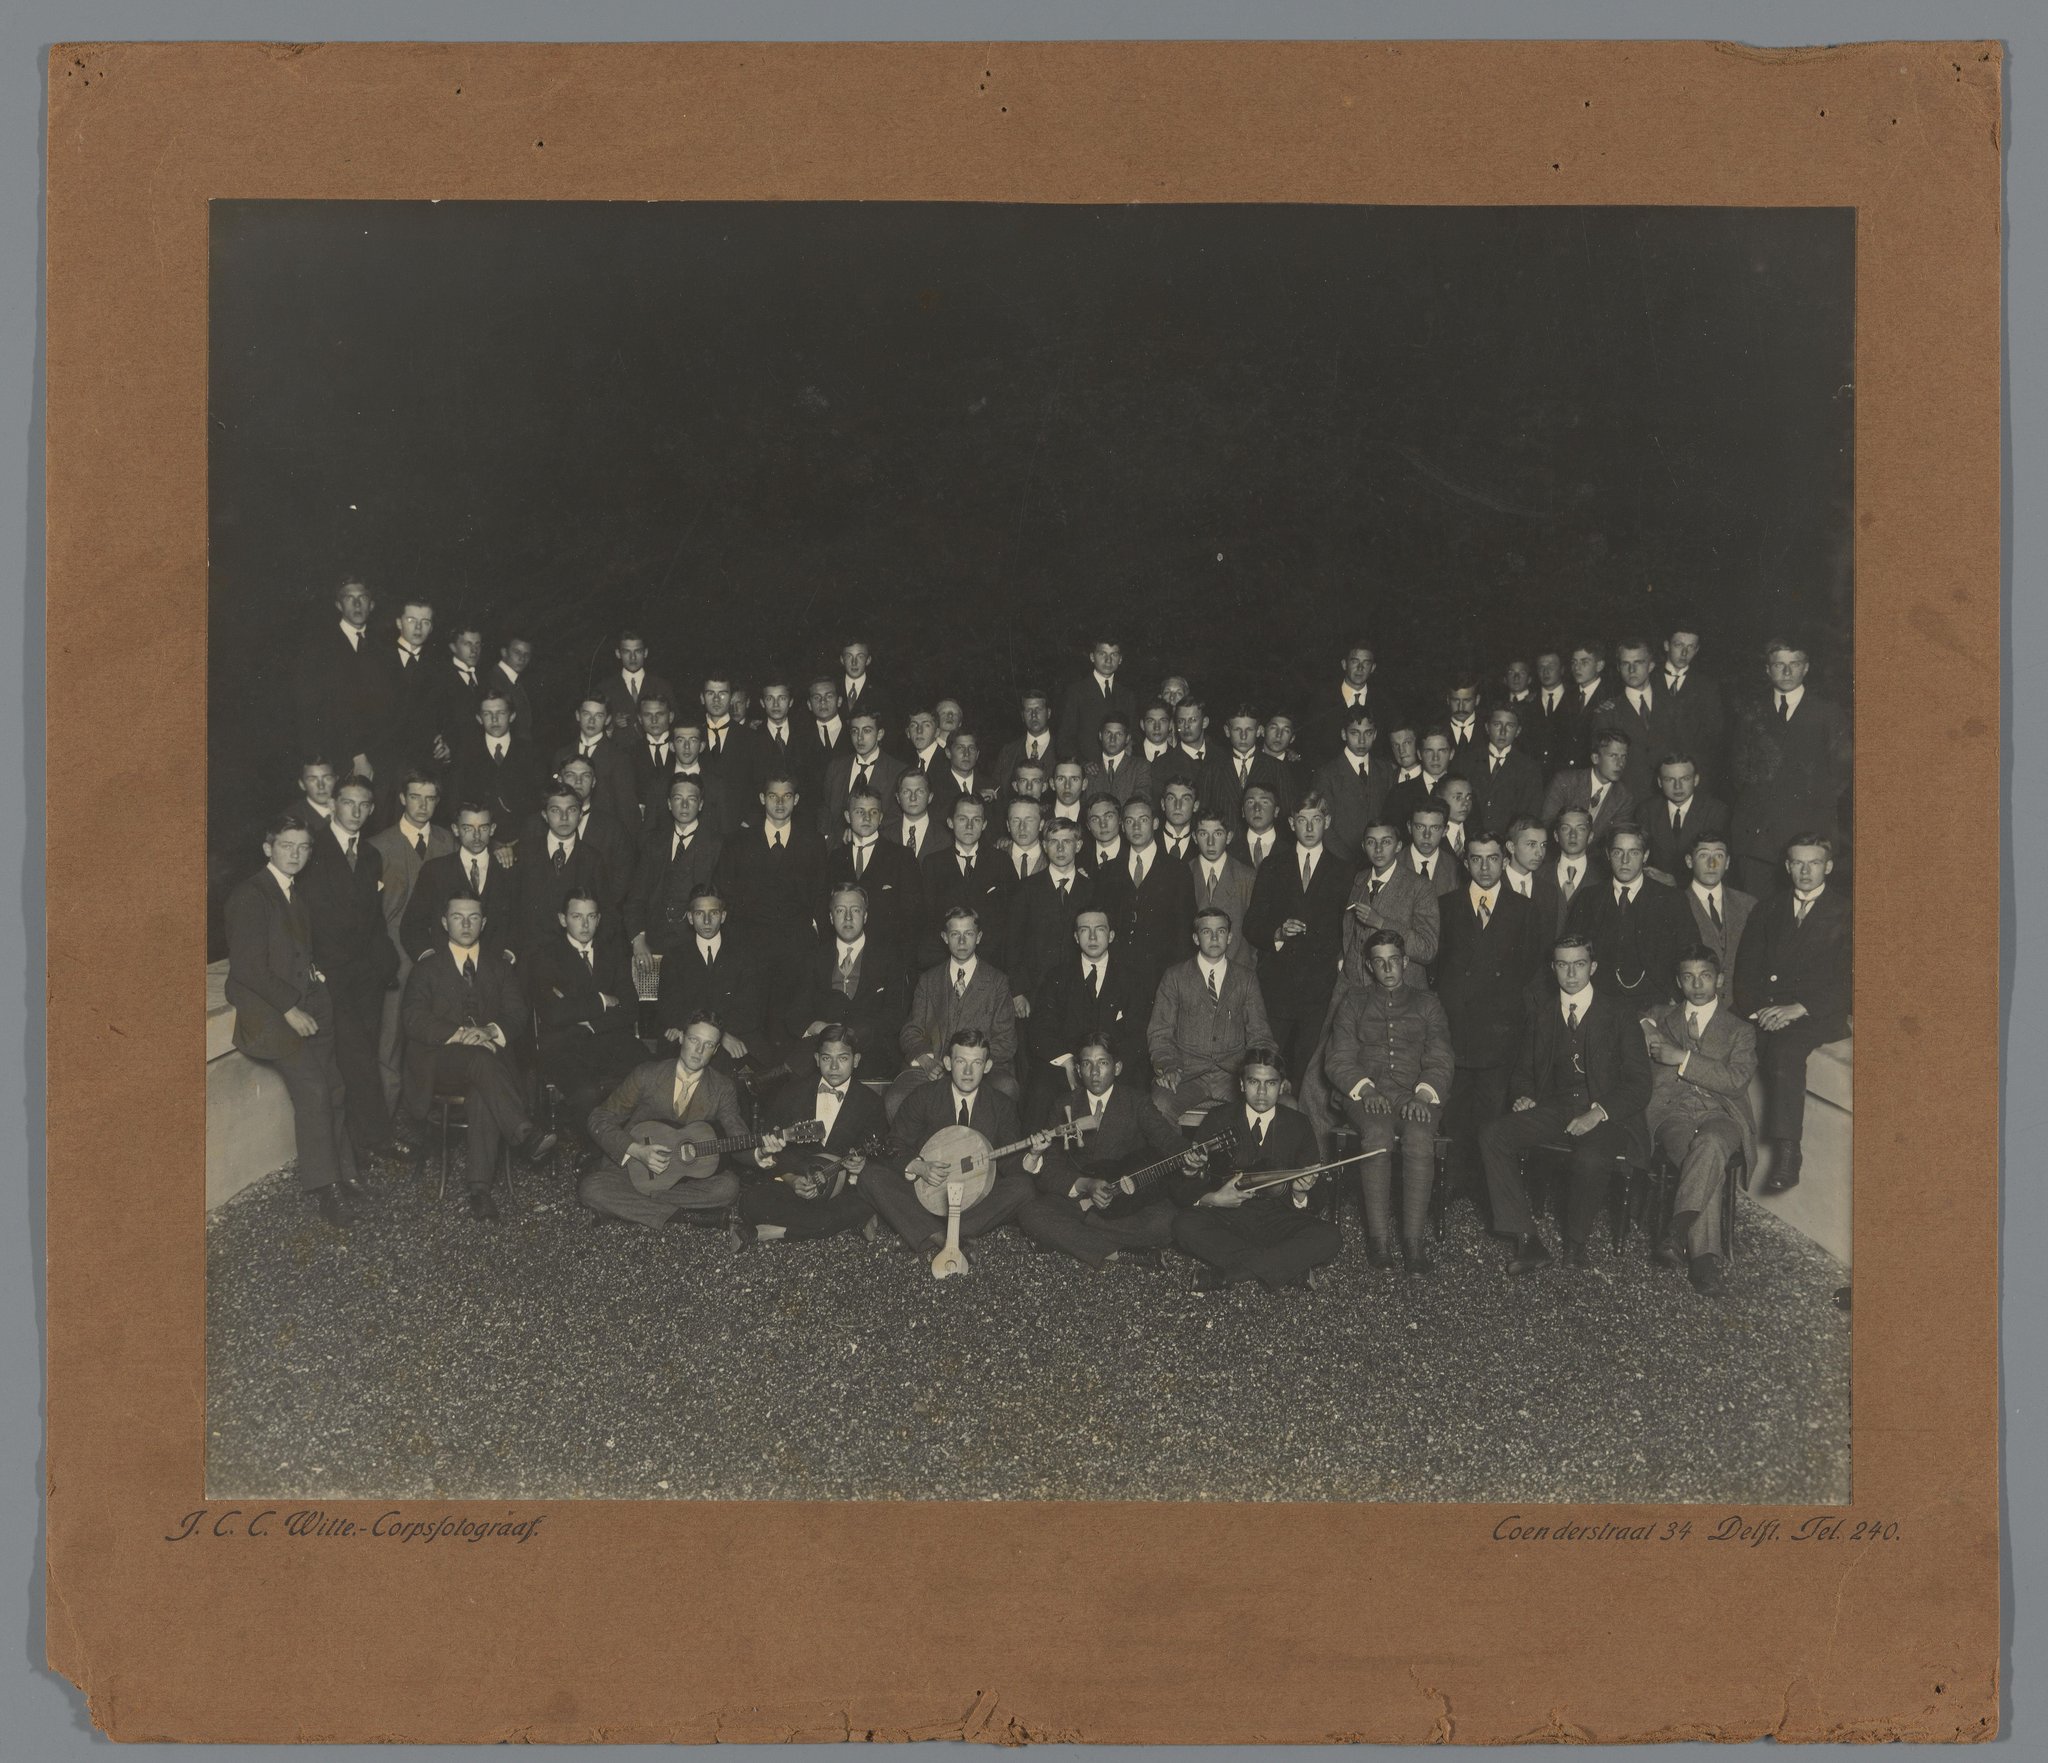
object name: photograph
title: Groepsportret, mogelijk van eerstejaars van het Delftsch Studenten Corps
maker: j.c.c. witte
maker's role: fotograaf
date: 1914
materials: paper, cardboard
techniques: gelatin silver print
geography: delft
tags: rowing facing backward, pulling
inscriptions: address: ‘J.C.C. Witte. -Corpsfotograaf. Coenderstraat 34, Delft. Tel. 240.’, inscription: ‘Groenkiek 1914.’